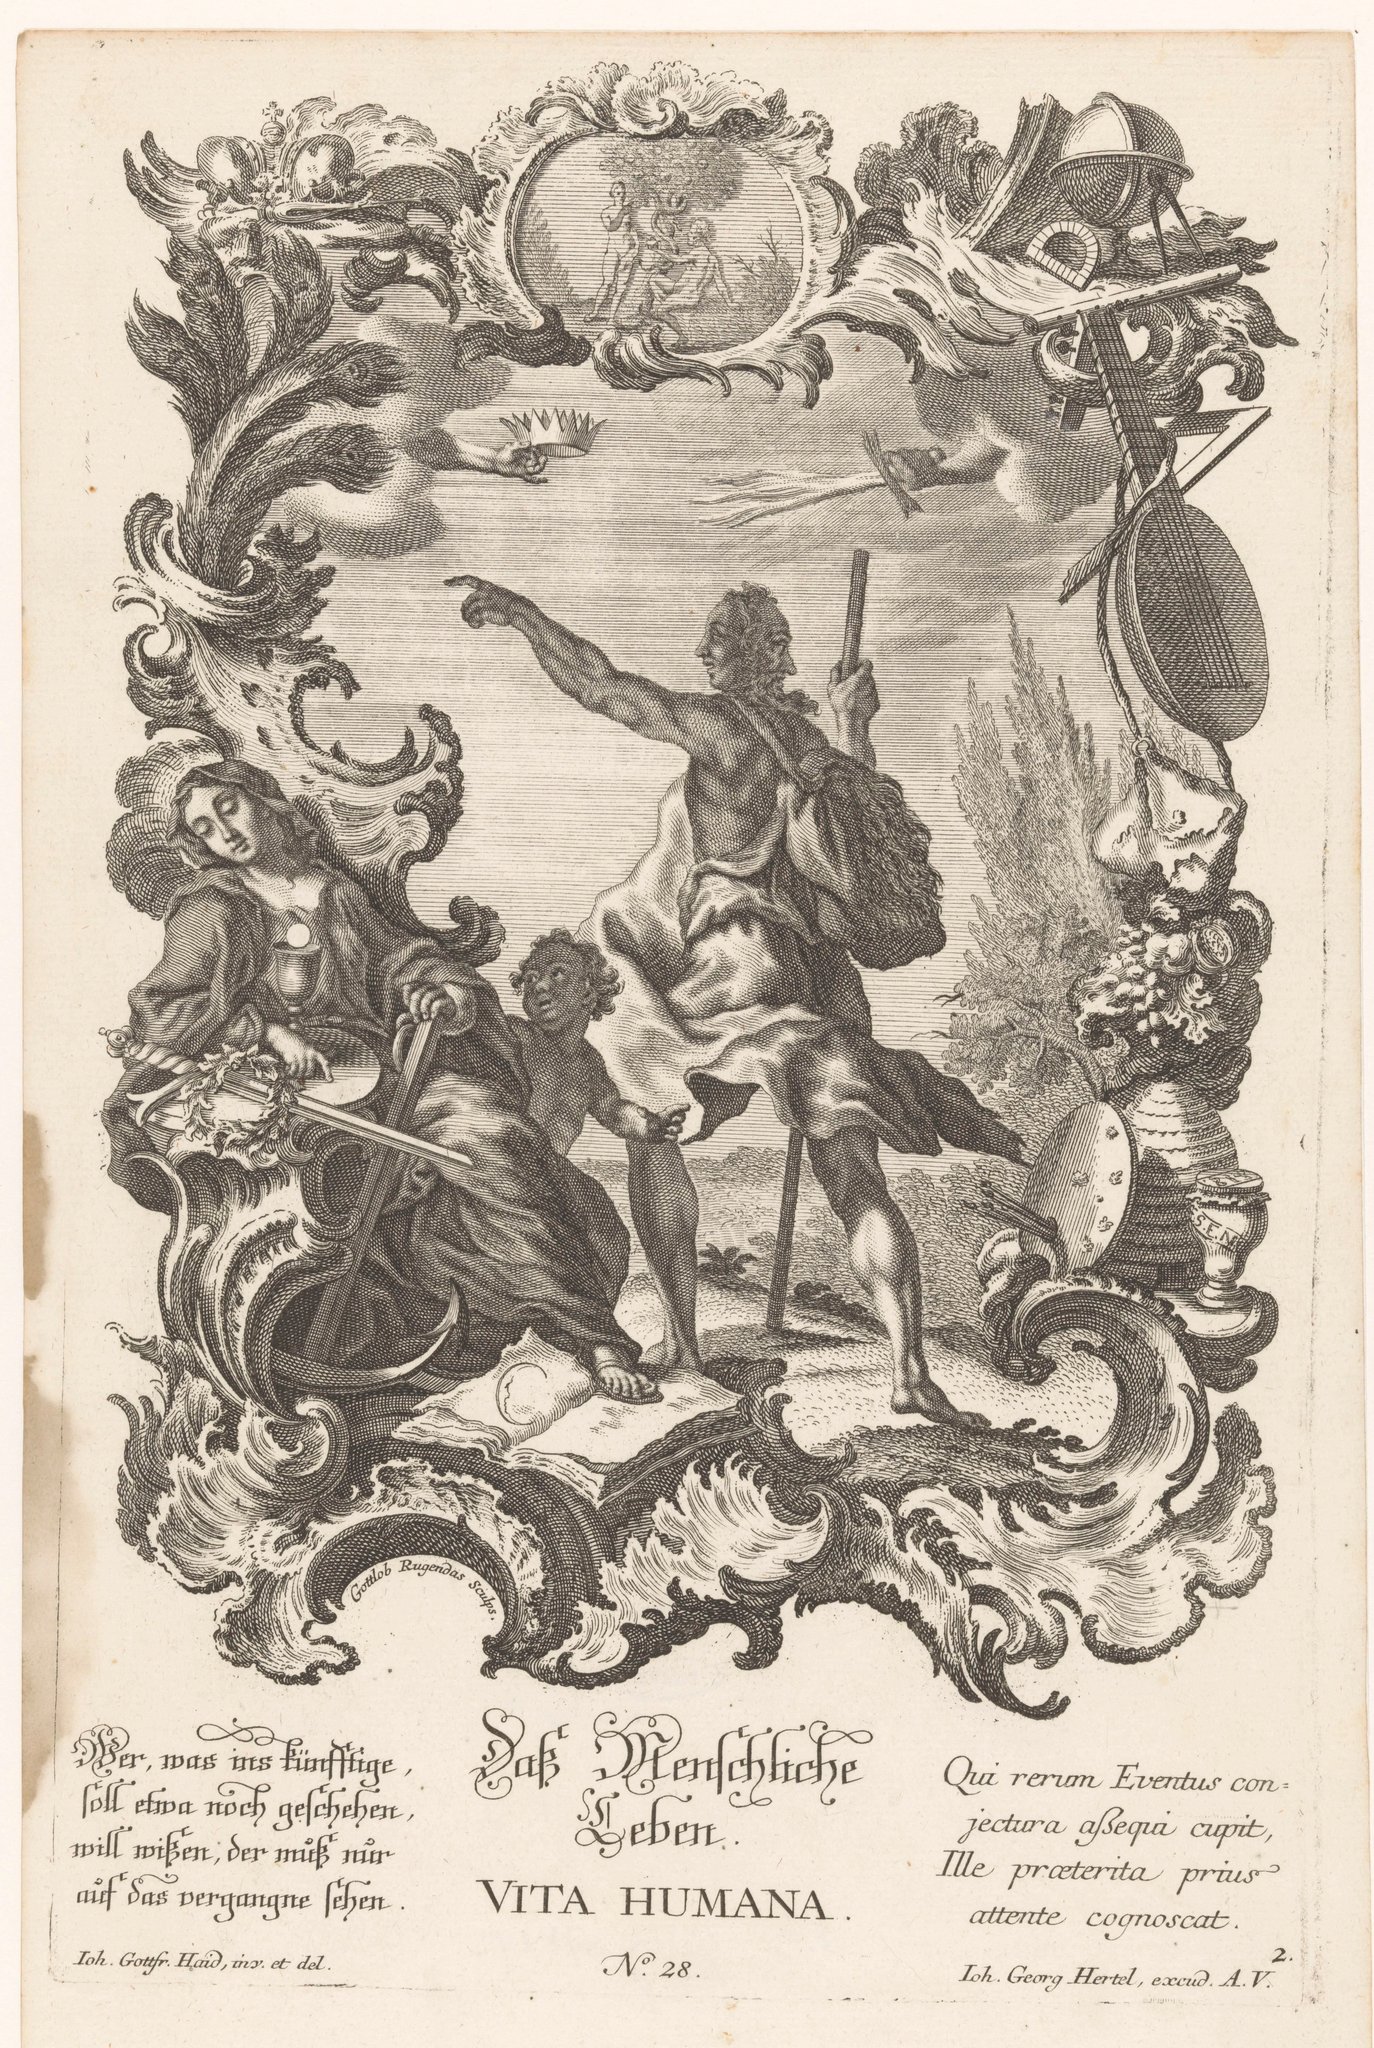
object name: print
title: Daß Menschliche Leben/ Vita Humana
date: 1745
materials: paper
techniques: etching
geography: augsburg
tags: human life; 'vita humana', 'vita inquieta', 'vita e l'animo' (ripa), (story of) janus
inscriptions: collector's mark: Lugt 2228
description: Allegorie van het menselijk leven, omgeven door rocaille omlijsting. Links zit een vrouw met een kelk met hostie, een zwaard, een lauwerkrans en een anker. Haar voet rust op een boek met afbeelding van de maan. In het landschap achter haar loopt een man met twee gezichten, de god Janus. In de ondermarge tweemaal een vierregelige Duits en Latijnse tekst. Uitgeversnummer 28.